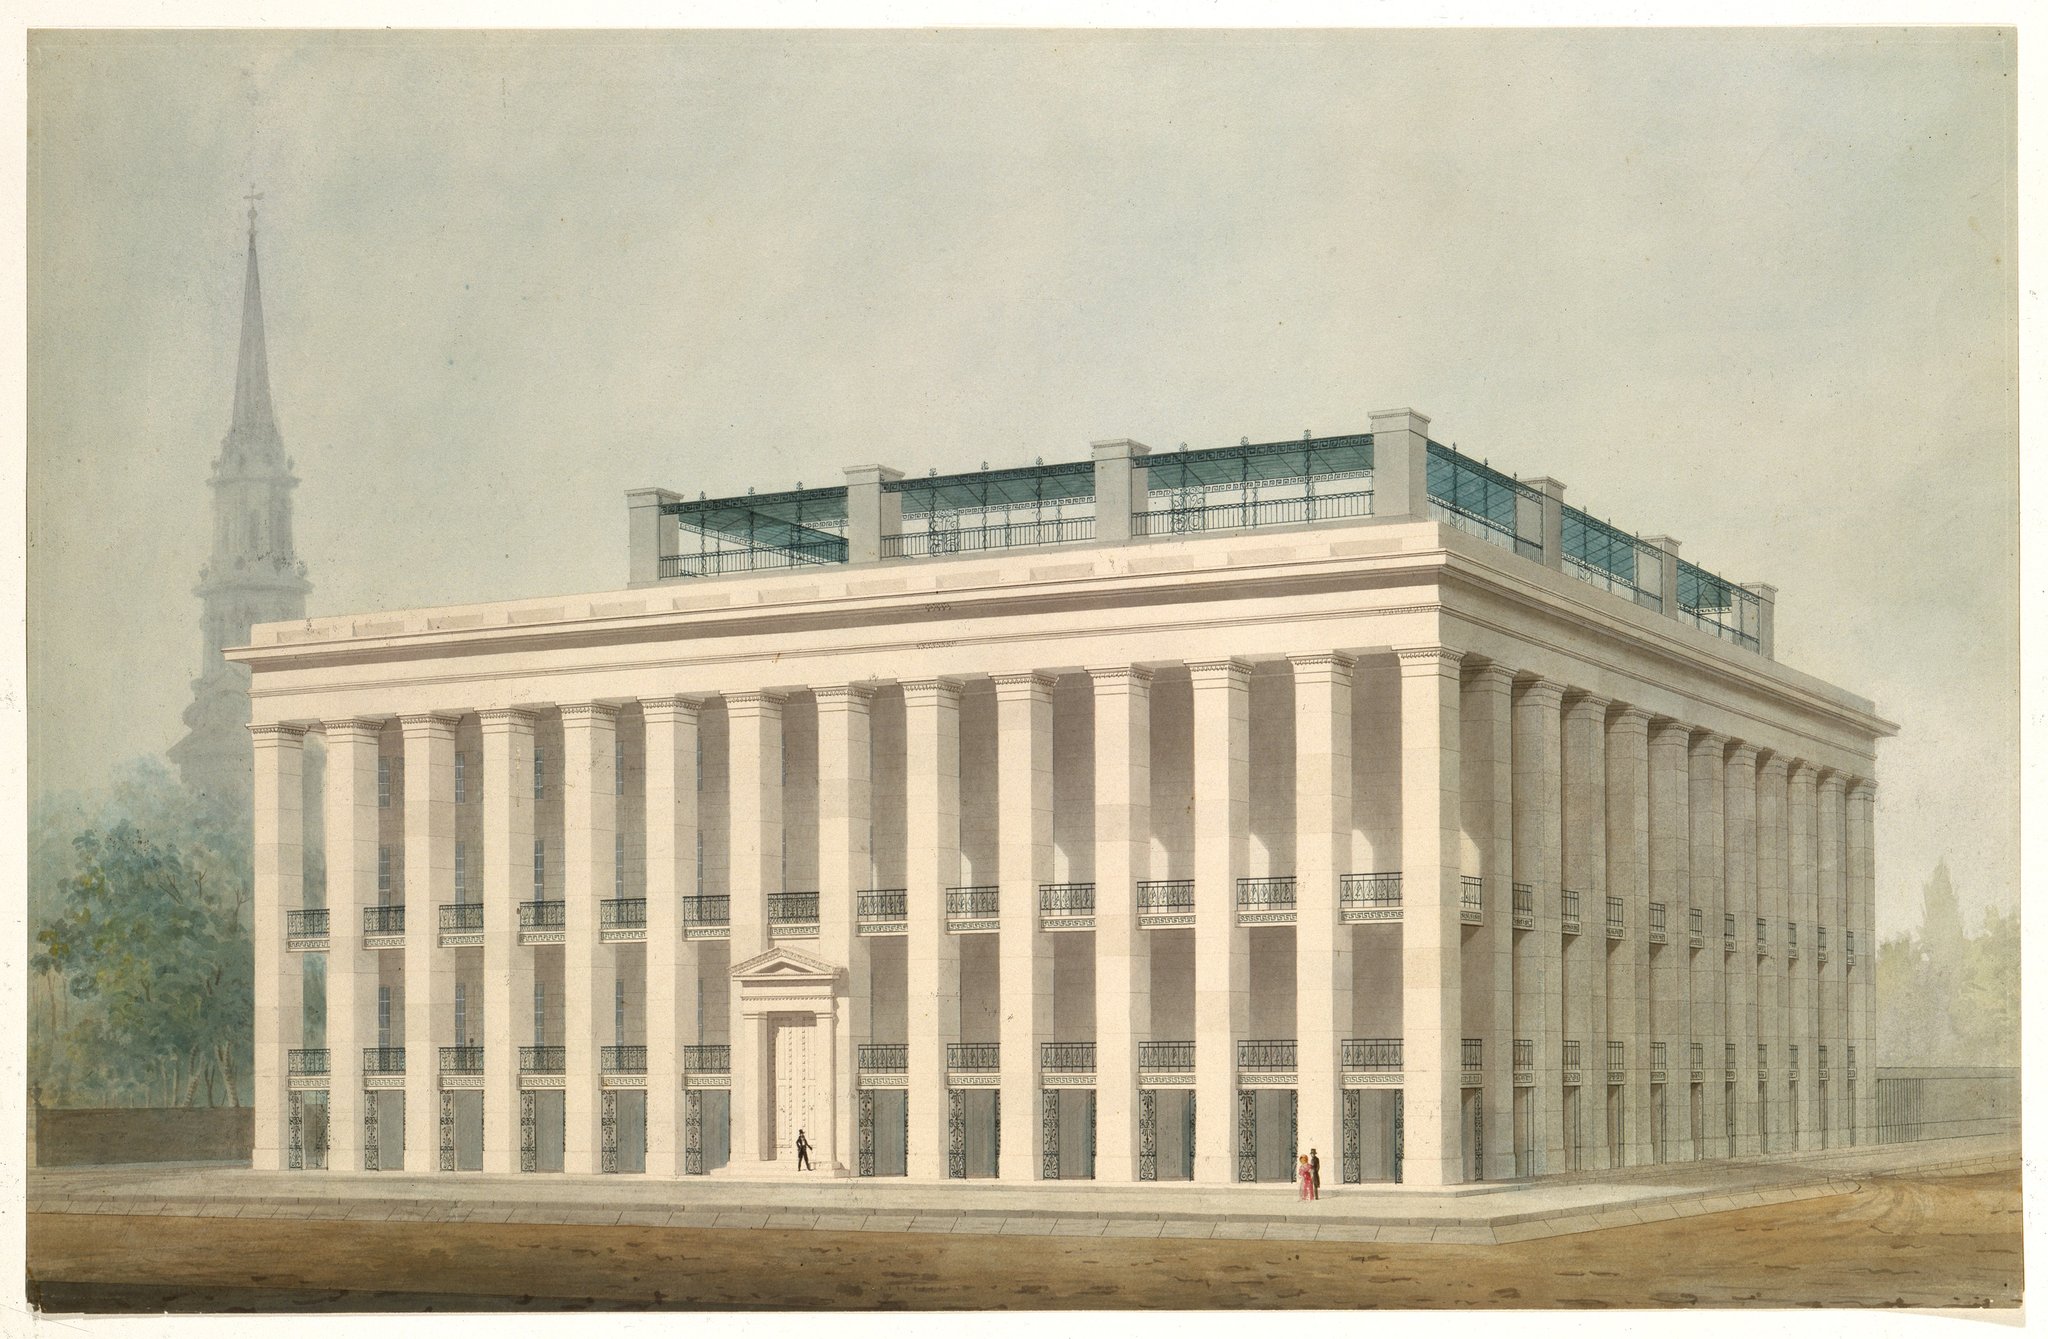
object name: drawing ornament architecture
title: Proposal for Astor House (Park Hotel), New York (perspective)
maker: ithiel town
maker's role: architect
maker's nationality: american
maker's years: 1784-1844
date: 1830-1834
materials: graphite, ink, paper, watercolor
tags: architecture,hotels